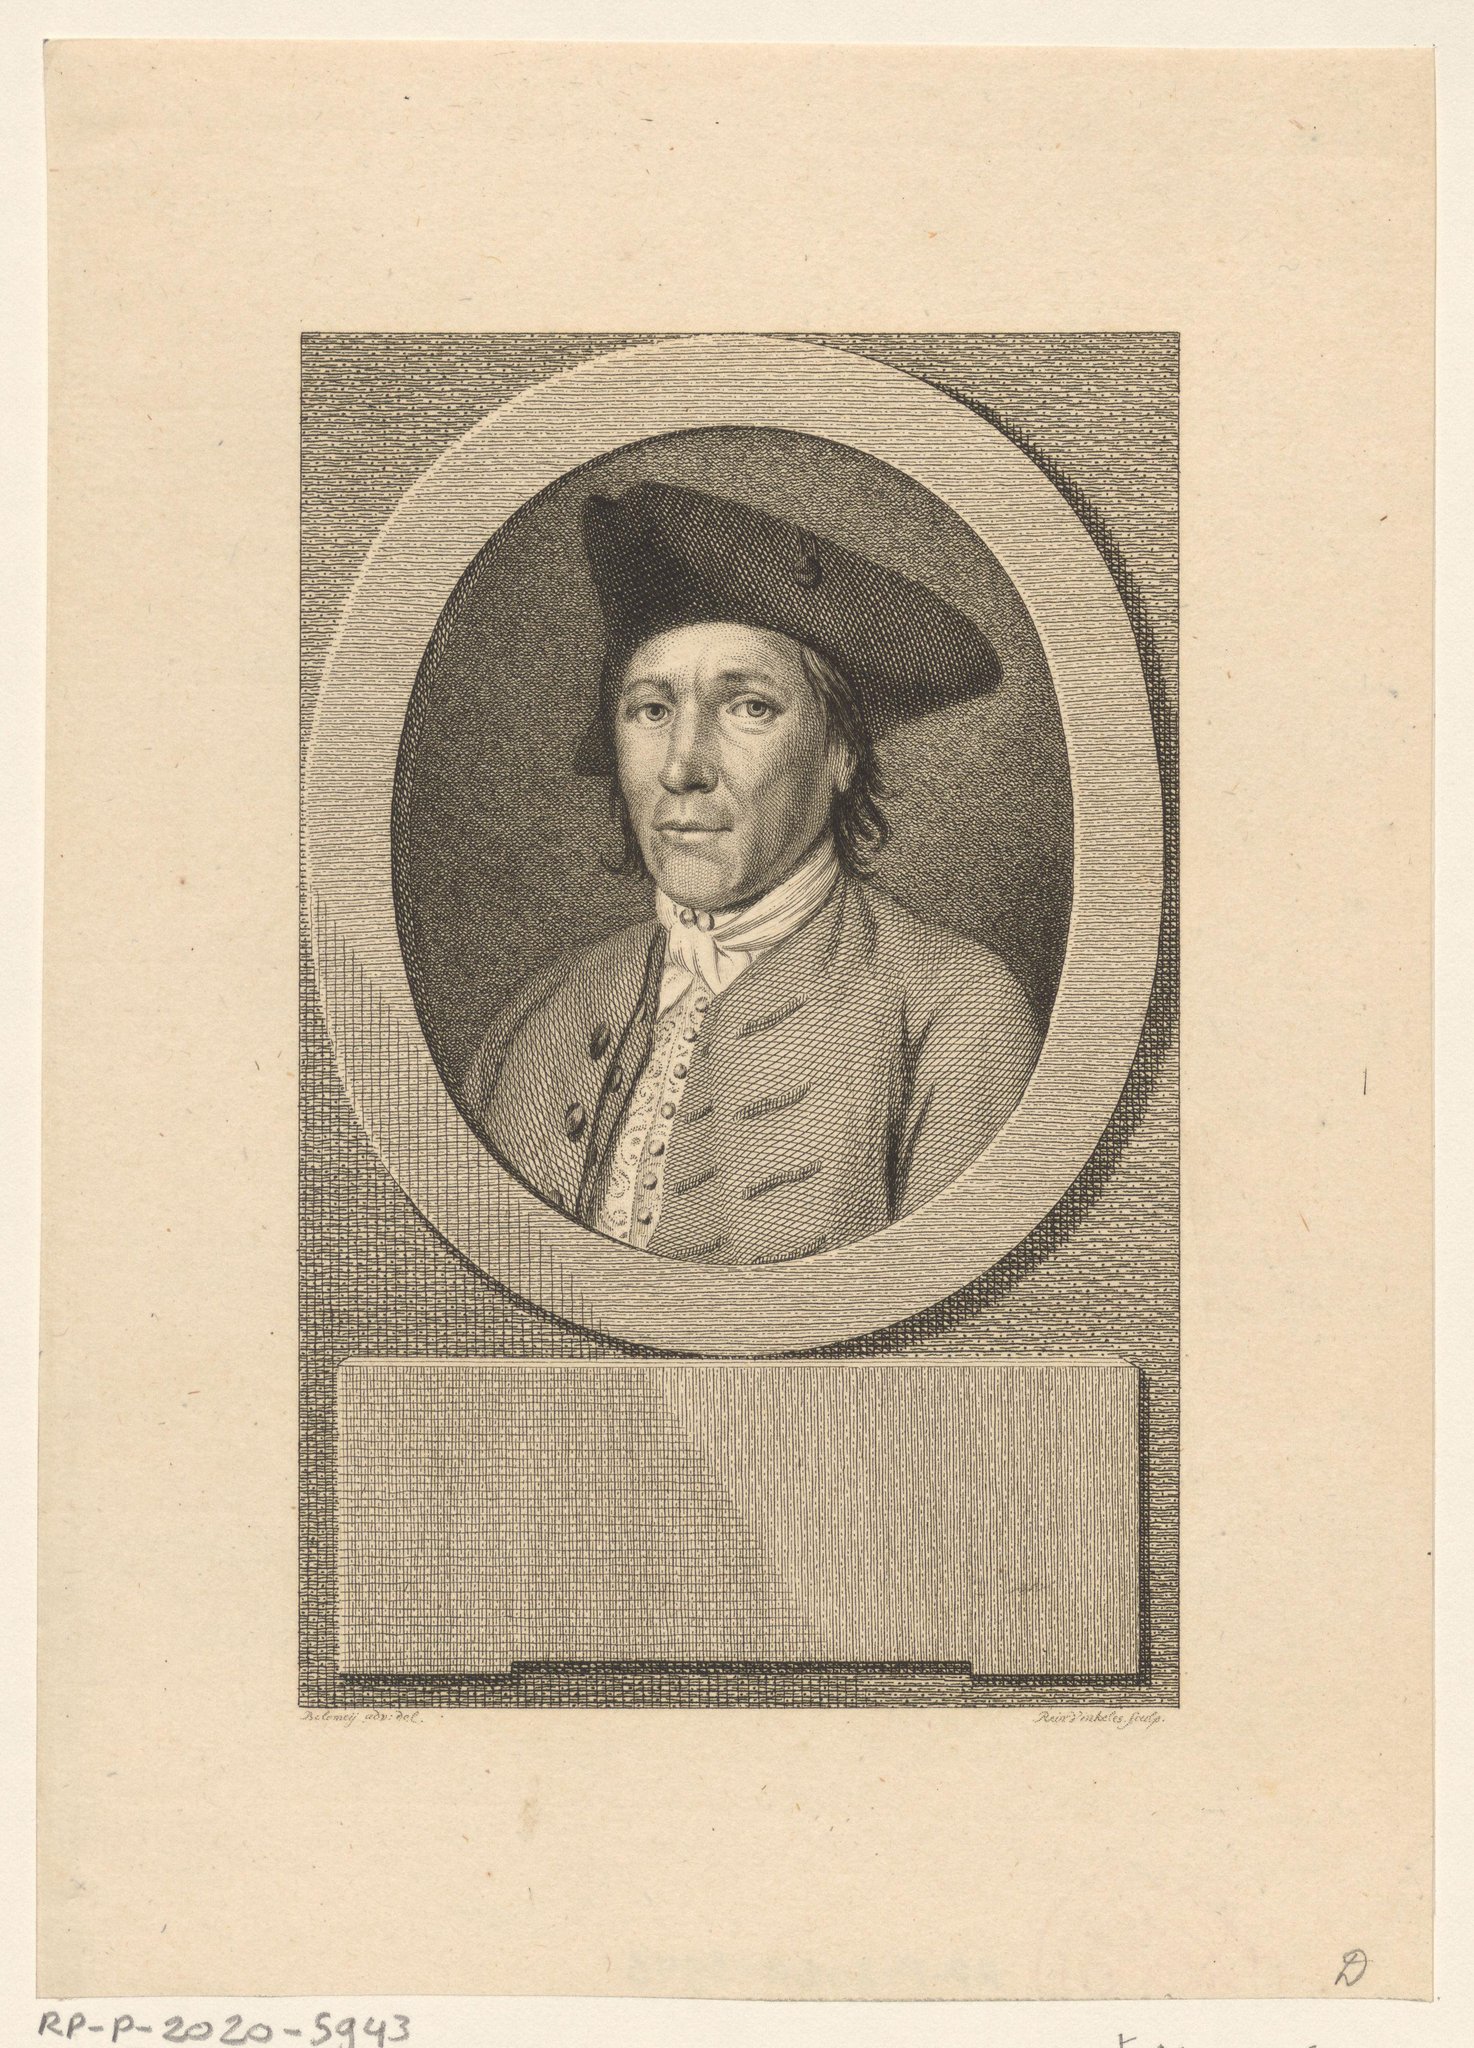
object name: print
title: Portret van Jacob van Dijk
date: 1789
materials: paper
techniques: etching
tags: historical persons, writer, poet, author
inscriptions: collector's mark: Lugt 240